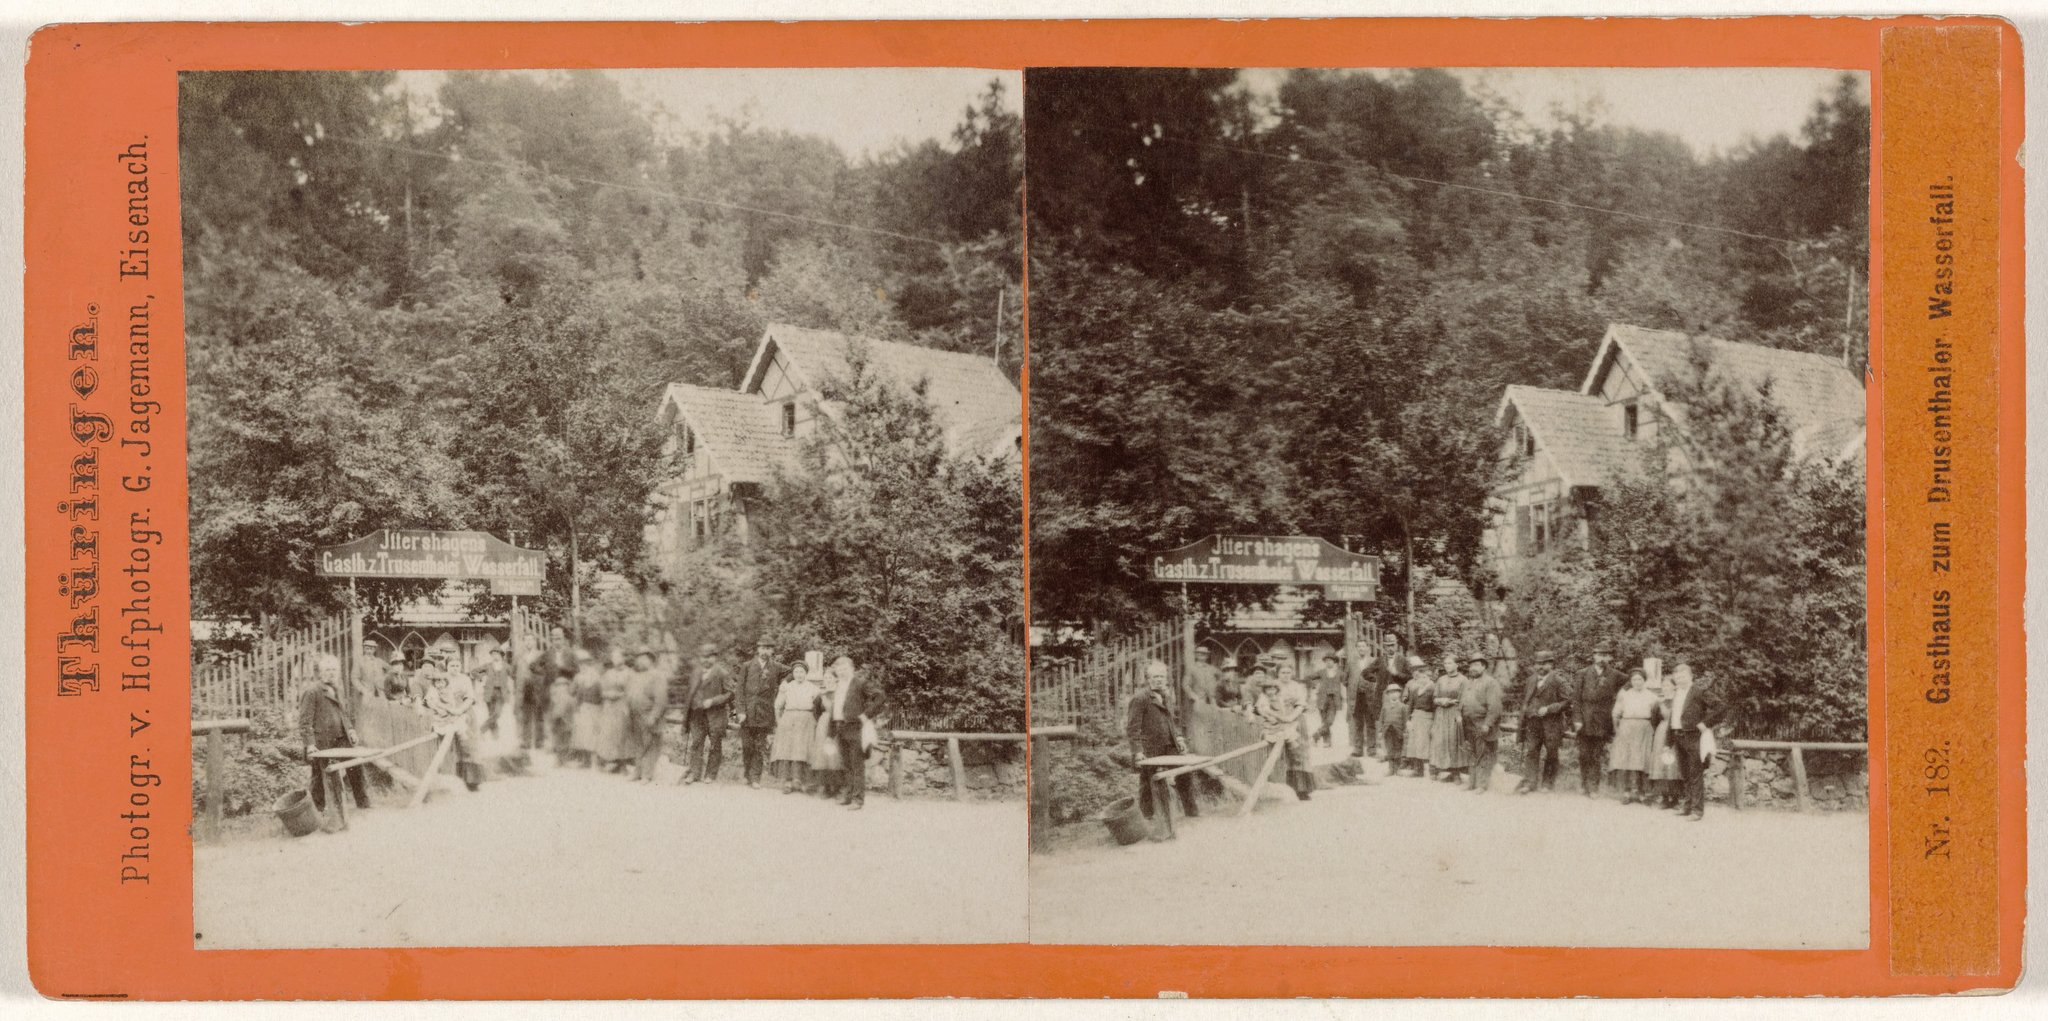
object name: stereograph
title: Mensen voor een herberg in Trusetal, Duitsland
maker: georg jagemann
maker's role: publisher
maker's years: 1817-1894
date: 1860-1890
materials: cardboard, paper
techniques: albumen print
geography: trusetal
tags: forest, wood, hotel, hostelry, inn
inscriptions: number: ‘Nr. 182.’